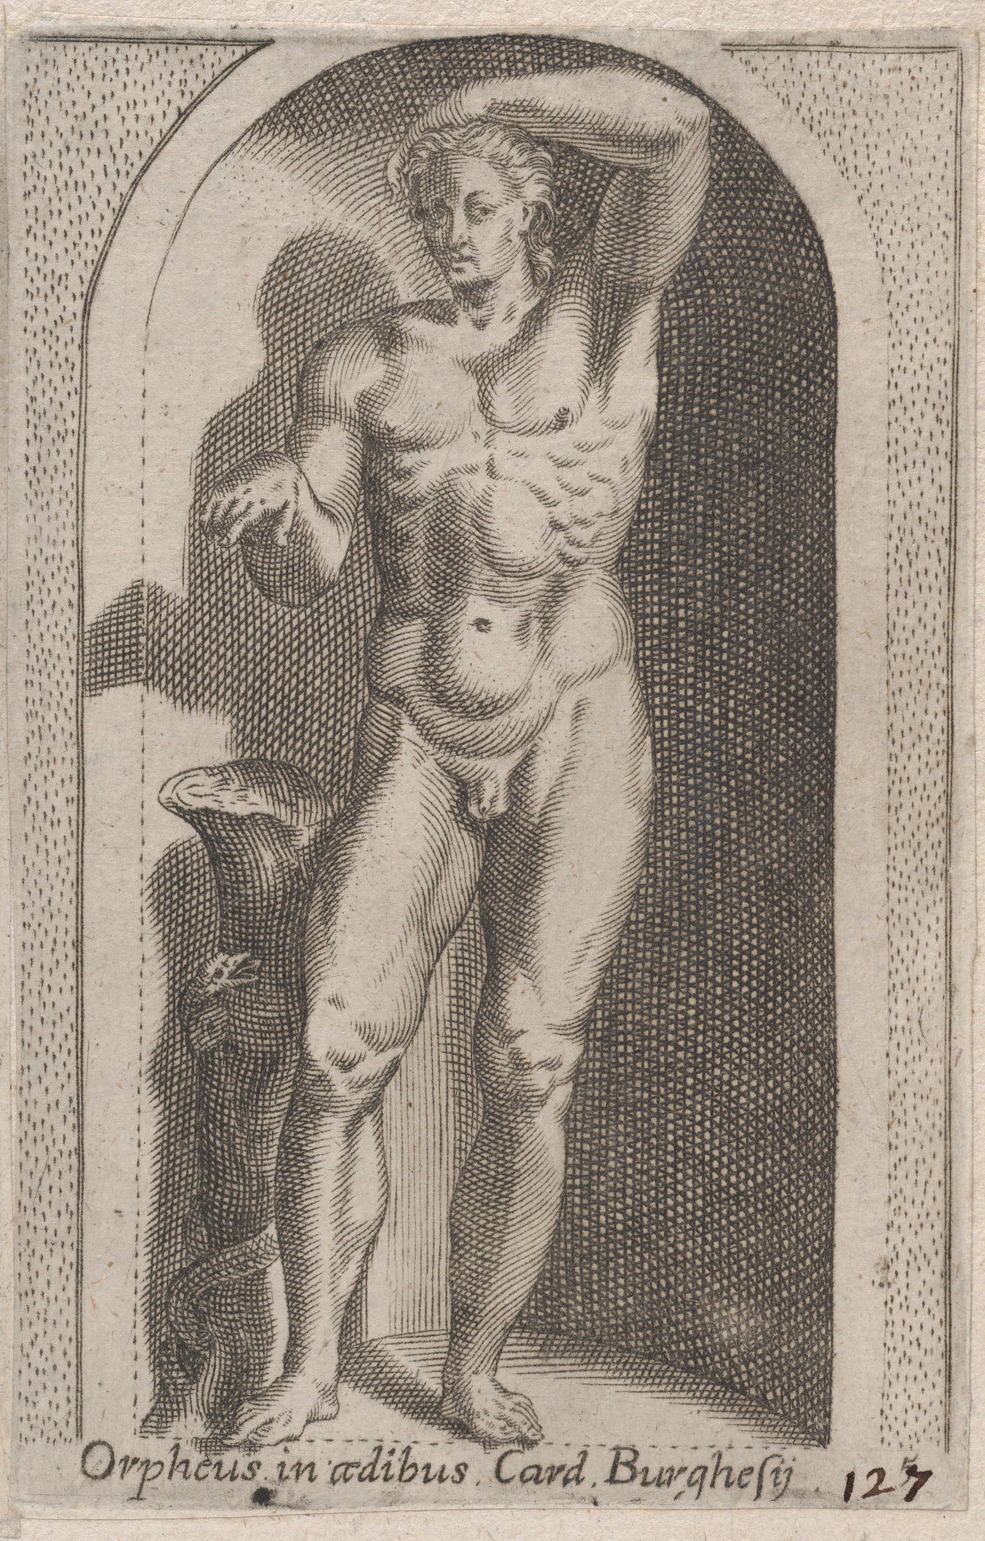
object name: print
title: Orpheus (Orpheus in aedibus Card. Burghesij), from "Speculum Romanae Magnificentiae"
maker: Anonymous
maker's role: artist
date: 1501-1600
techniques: engraving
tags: orpheus